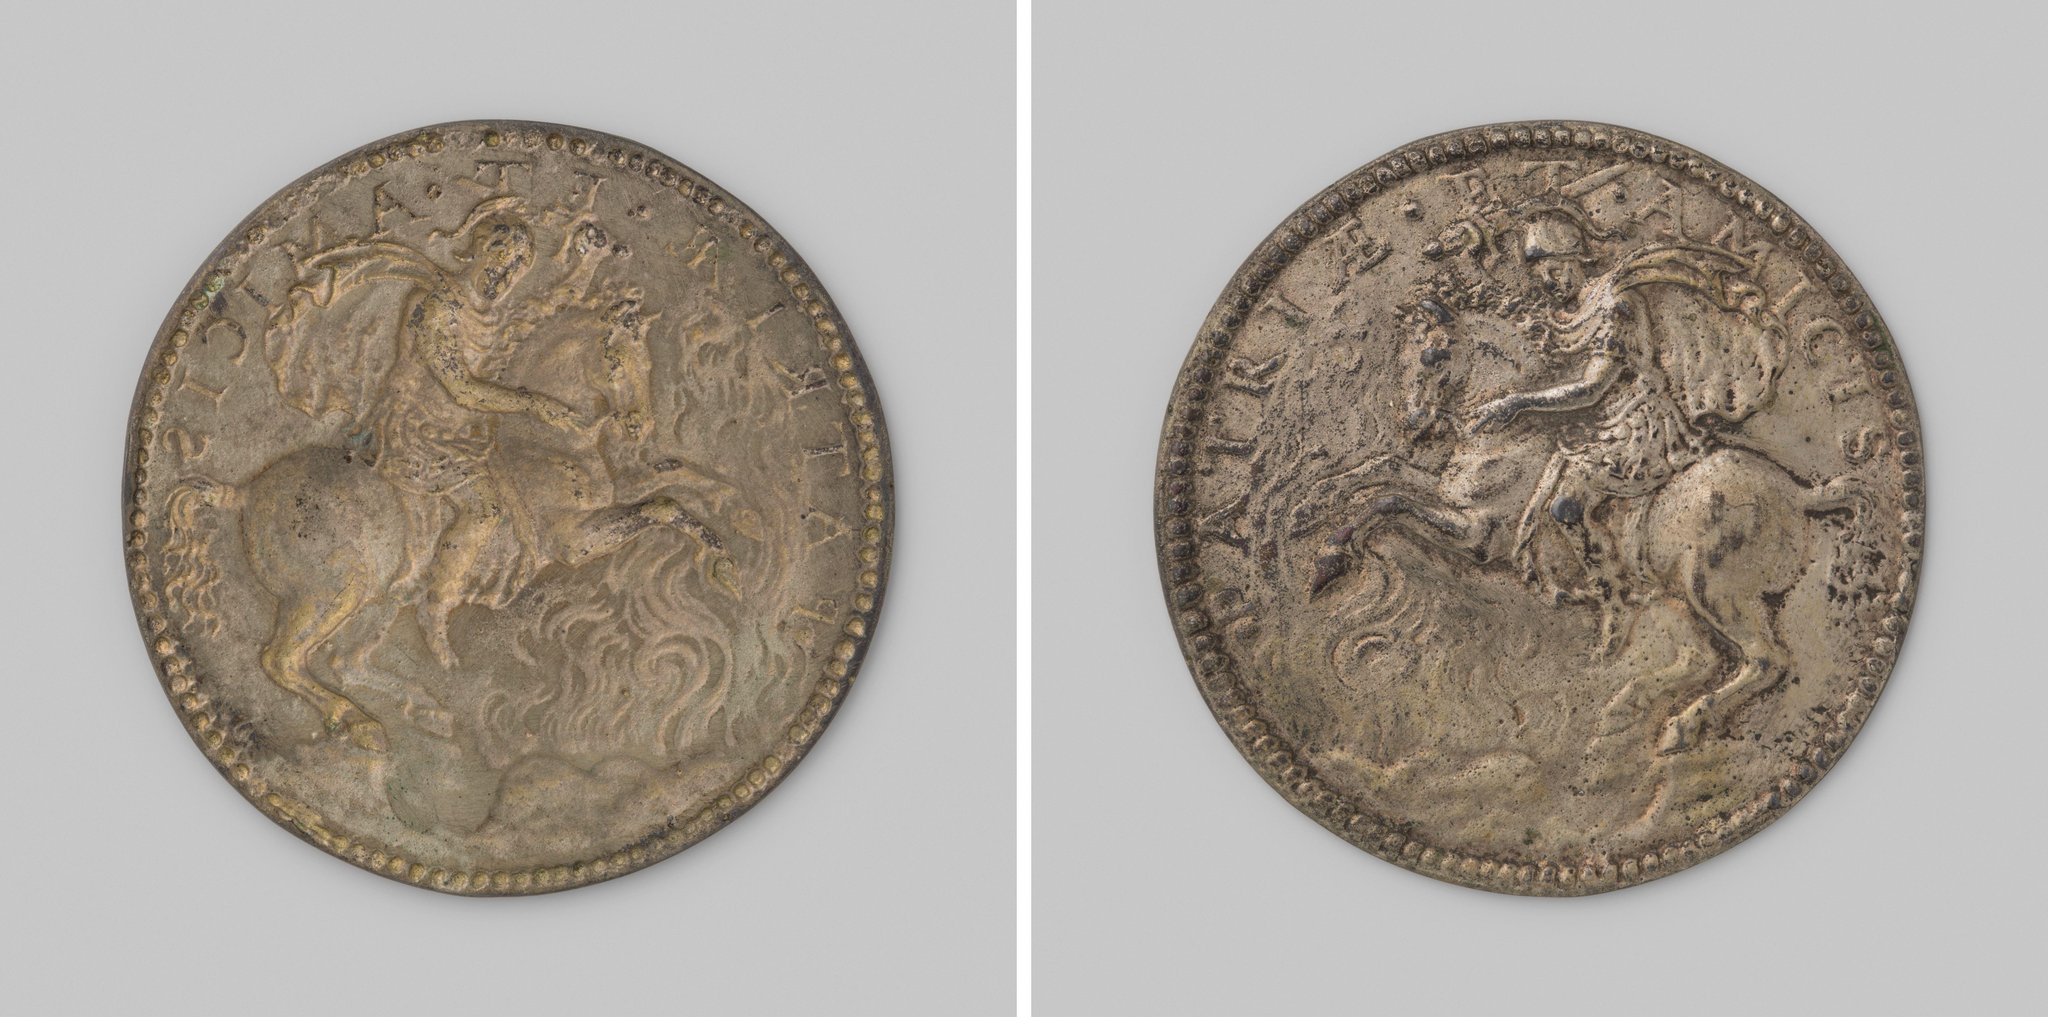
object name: copy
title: Paulus Pfintzig von Henfenfeld, raadsheer van Karel V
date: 1551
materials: silver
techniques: casting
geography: antwerp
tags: paulus pfintzing von hefenfeld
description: Eenzijdige zilveren penning. Voorzijde: blanco. Keerzijde: Marcus Curtius te paard voor de brandende poel binnen omschrift